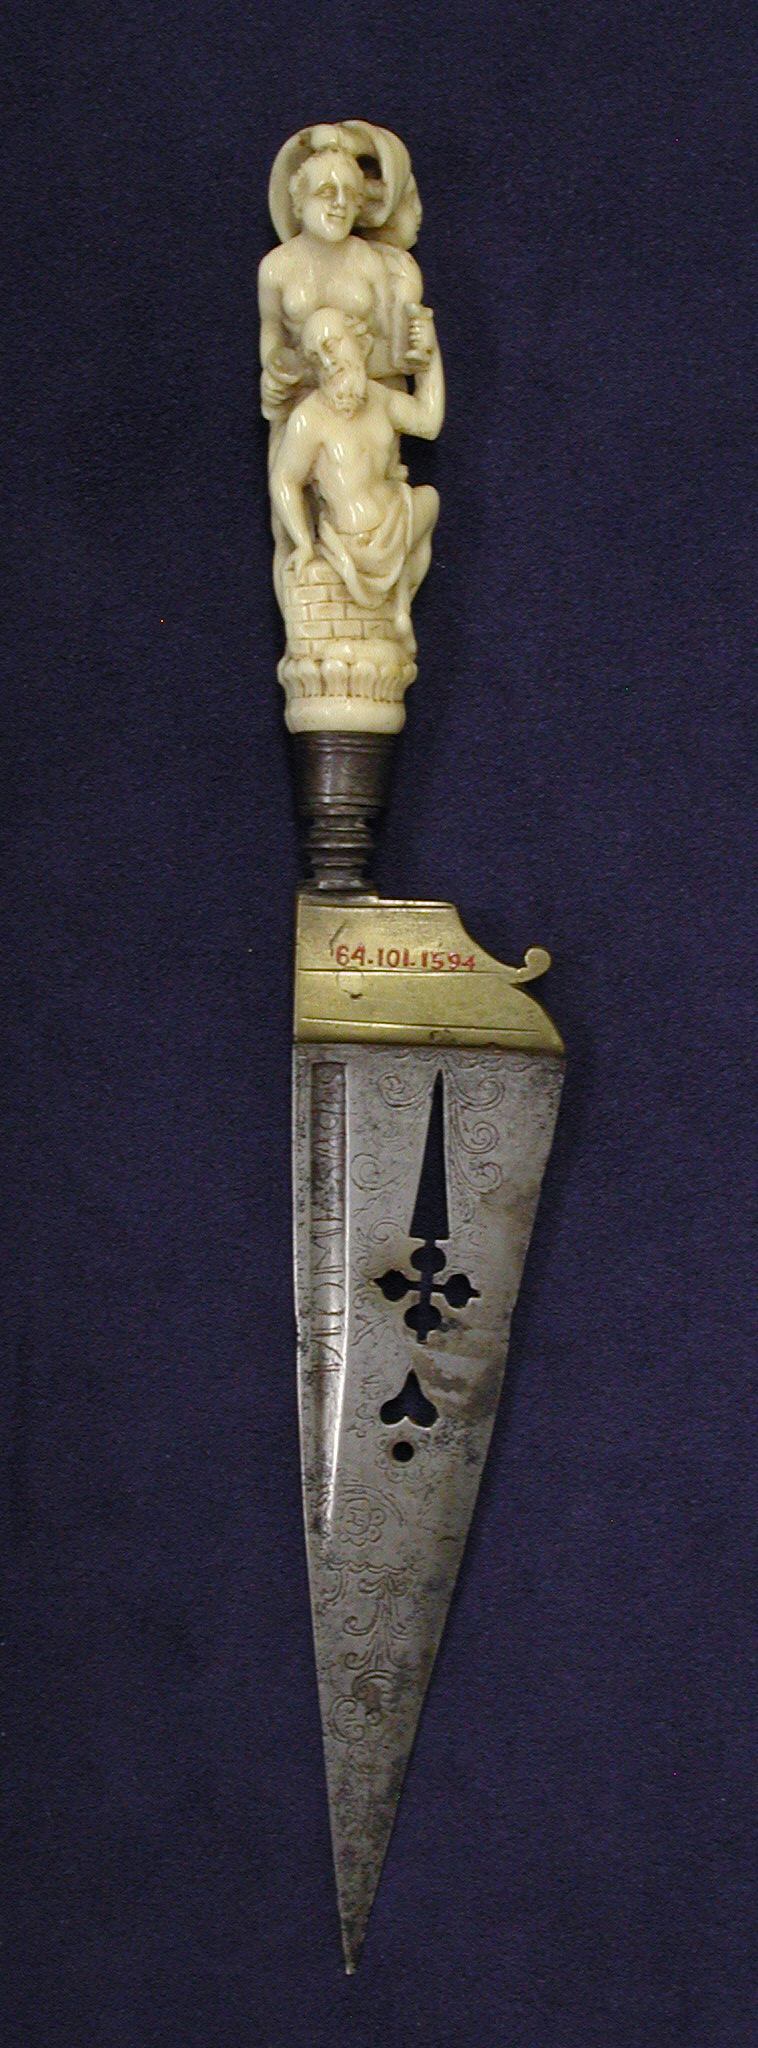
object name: knife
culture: blade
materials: brass, ivory, steel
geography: netherlands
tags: men,women